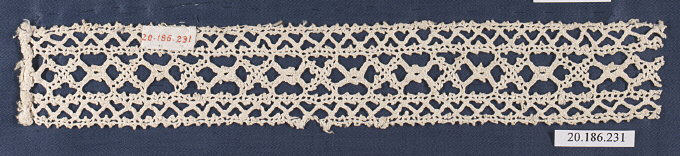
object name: insertion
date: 1501-1600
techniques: lace